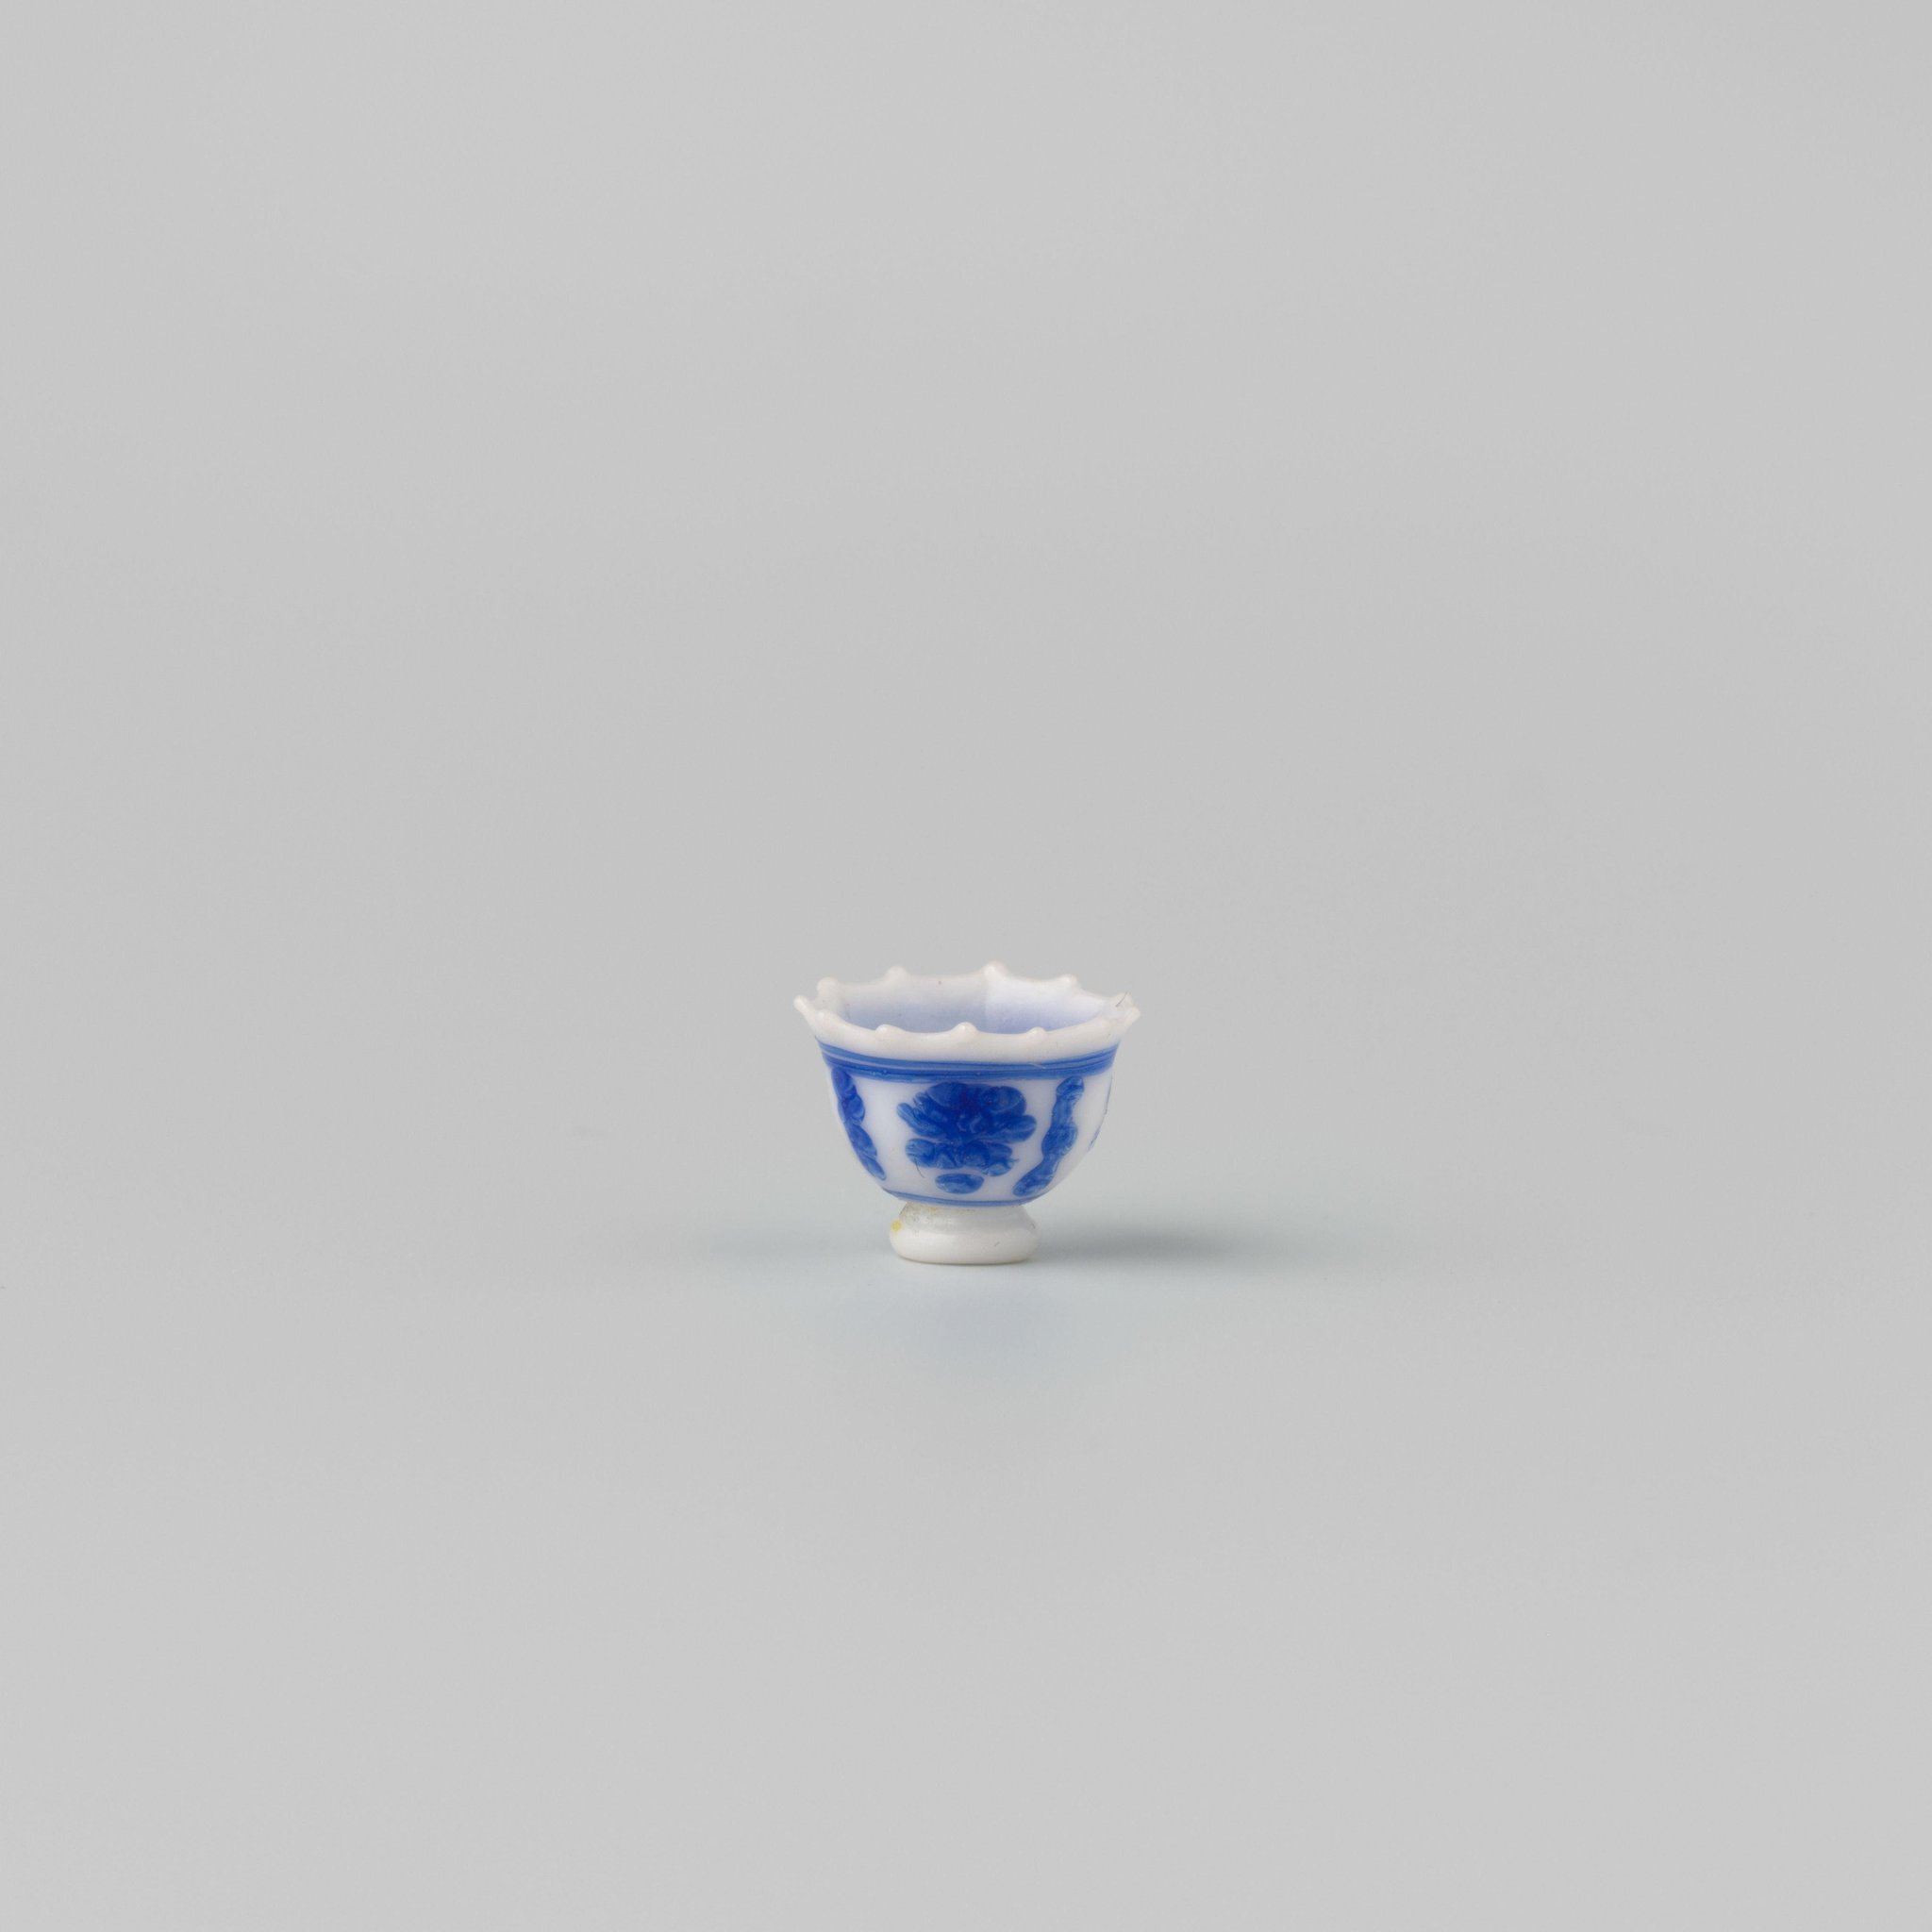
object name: tea cup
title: Theekopje van melkglas met blauwe emailverf beschildering, imitatie Chinees porselein met 'bloem' decoratie in vakken; model op los aangebrachte standring en met puntrand.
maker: Anonymous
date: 1675-1710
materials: glass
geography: amsterdam